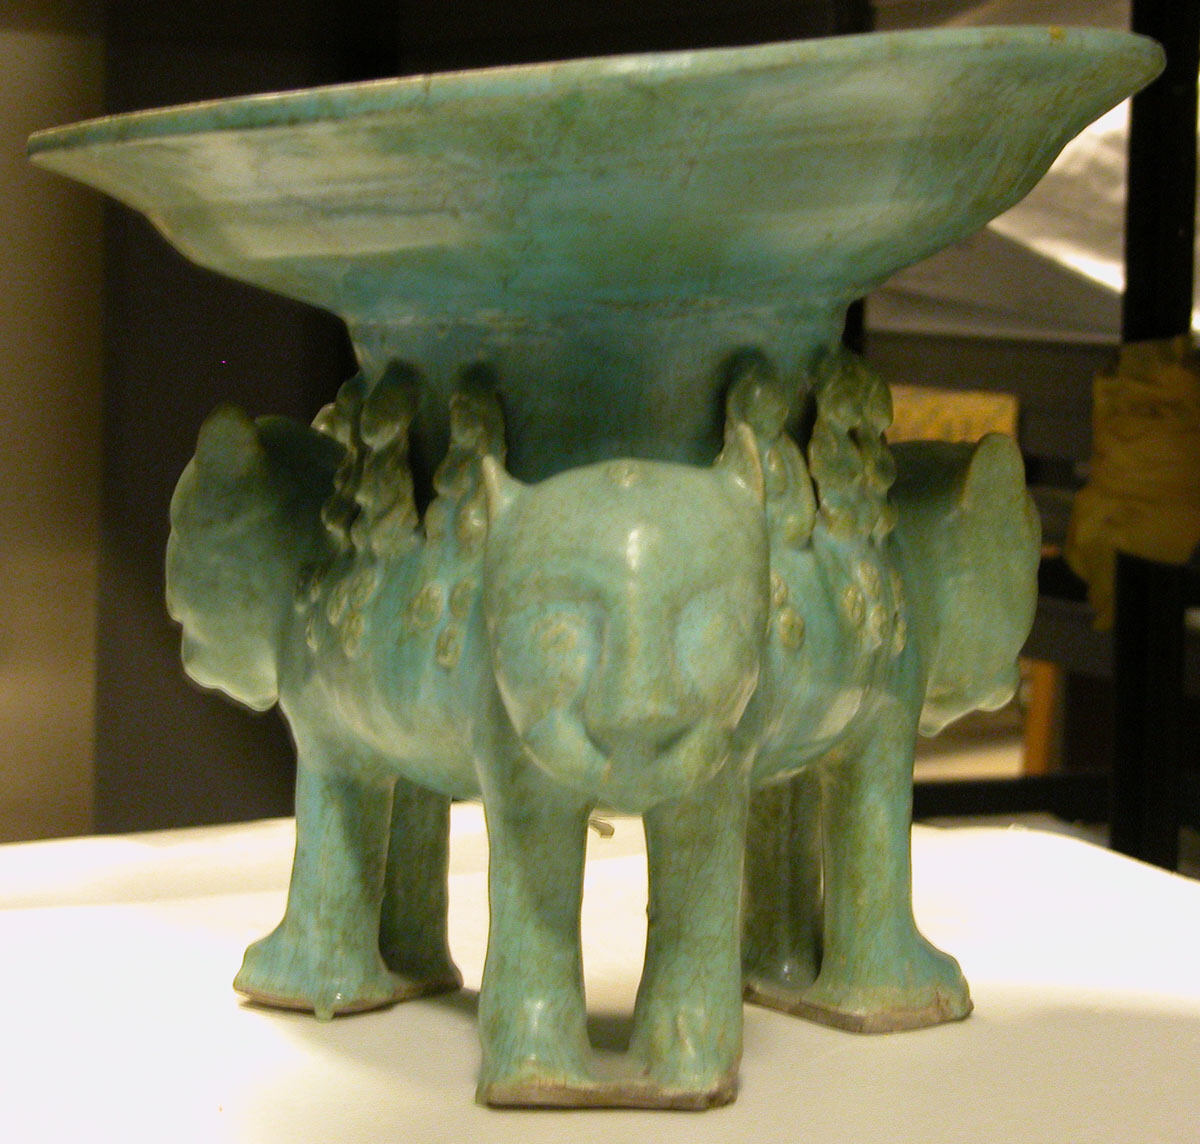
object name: footed bowl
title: Bowl on a Base of Three Molded Lions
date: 1101-1300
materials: stonepaste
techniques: glazing, molding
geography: iran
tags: lions